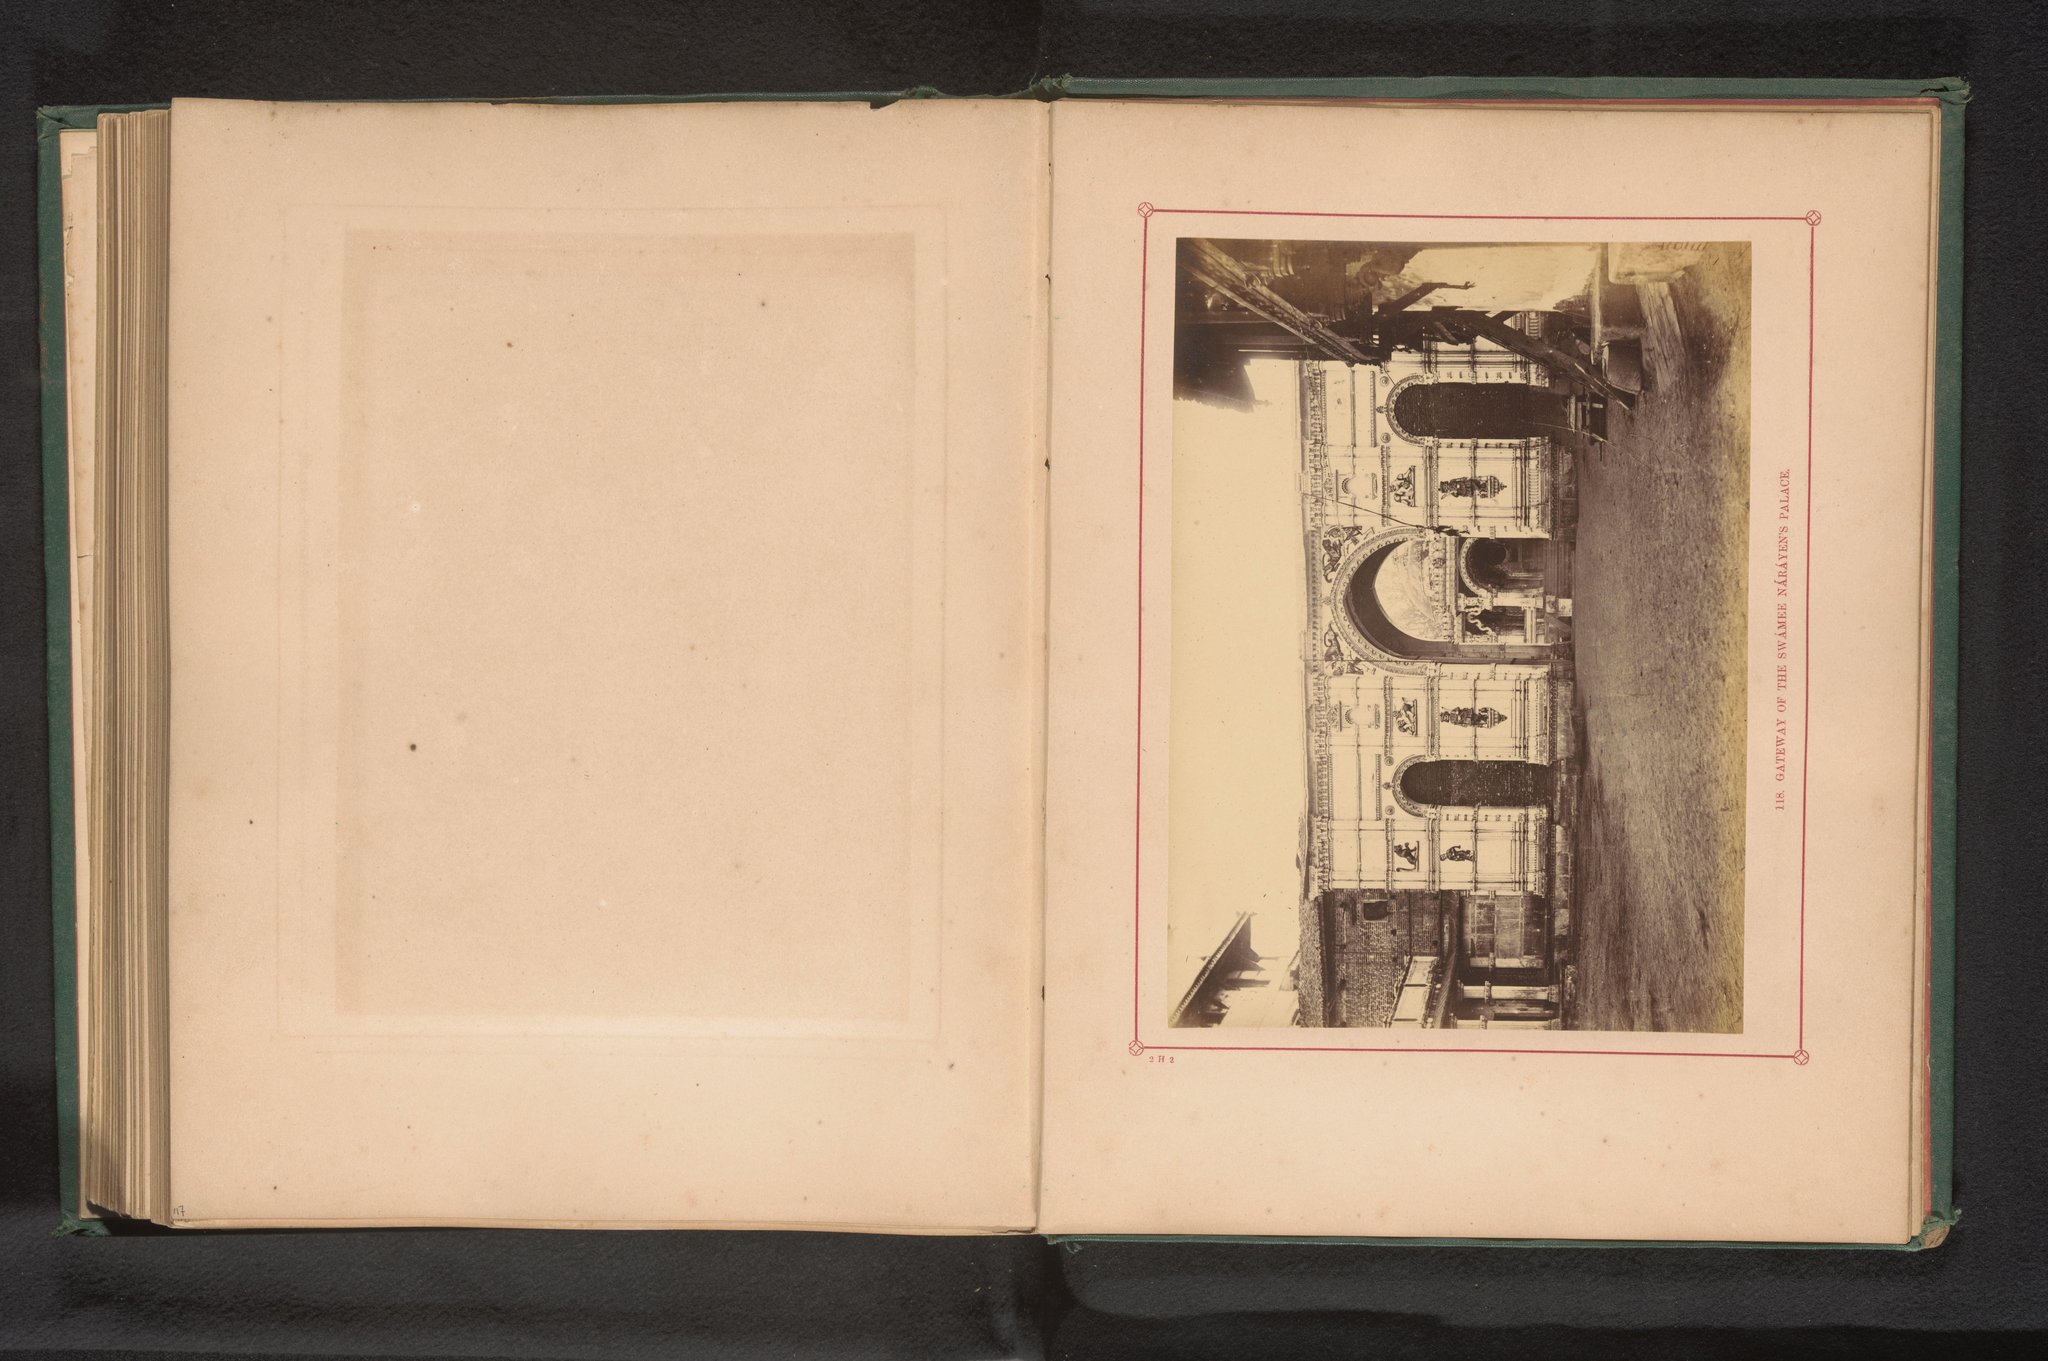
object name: photograph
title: Toegangspoort van vermoedelijk de Shri Swaminarayantempel in Ahmedabad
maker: thomas biggs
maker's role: fotograaf, kapitein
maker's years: 1822-1905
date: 1856-1866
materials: photographic support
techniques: albumen print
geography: ahmedabad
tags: places and objects of worship ~ hinduism, buddhism, jainism, gate, entrance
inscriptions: number: ‘118.’, inscription: ‘2H2’